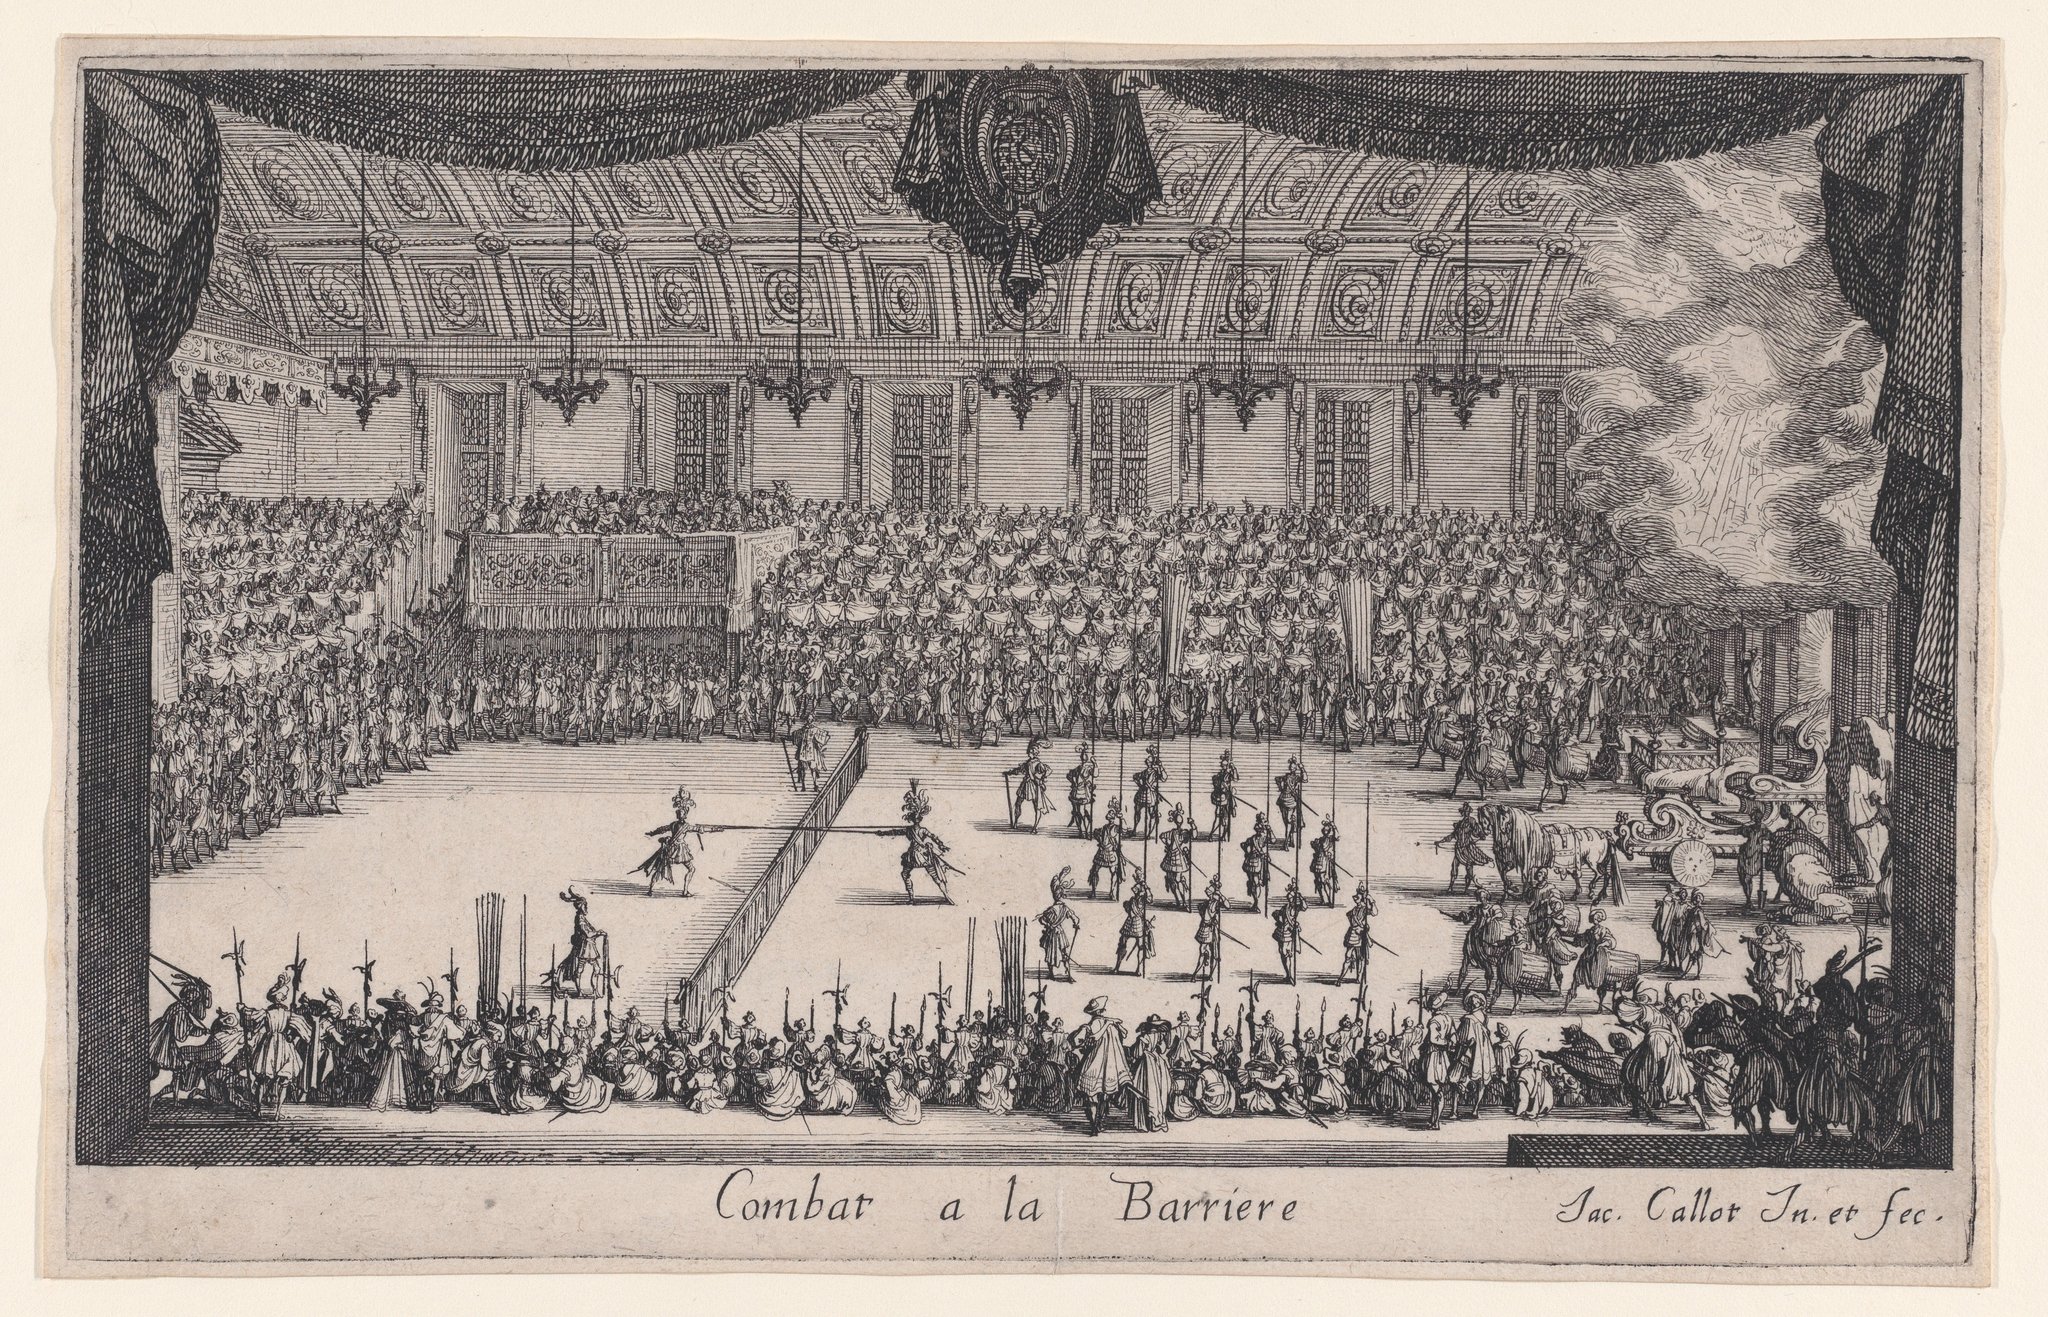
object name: print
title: Le Combat (The Combat), from "Le Combat a la Barrière in the Palace at Nancy"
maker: jacques callot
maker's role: artist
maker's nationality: french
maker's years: 1592-1635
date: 1627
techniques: etching